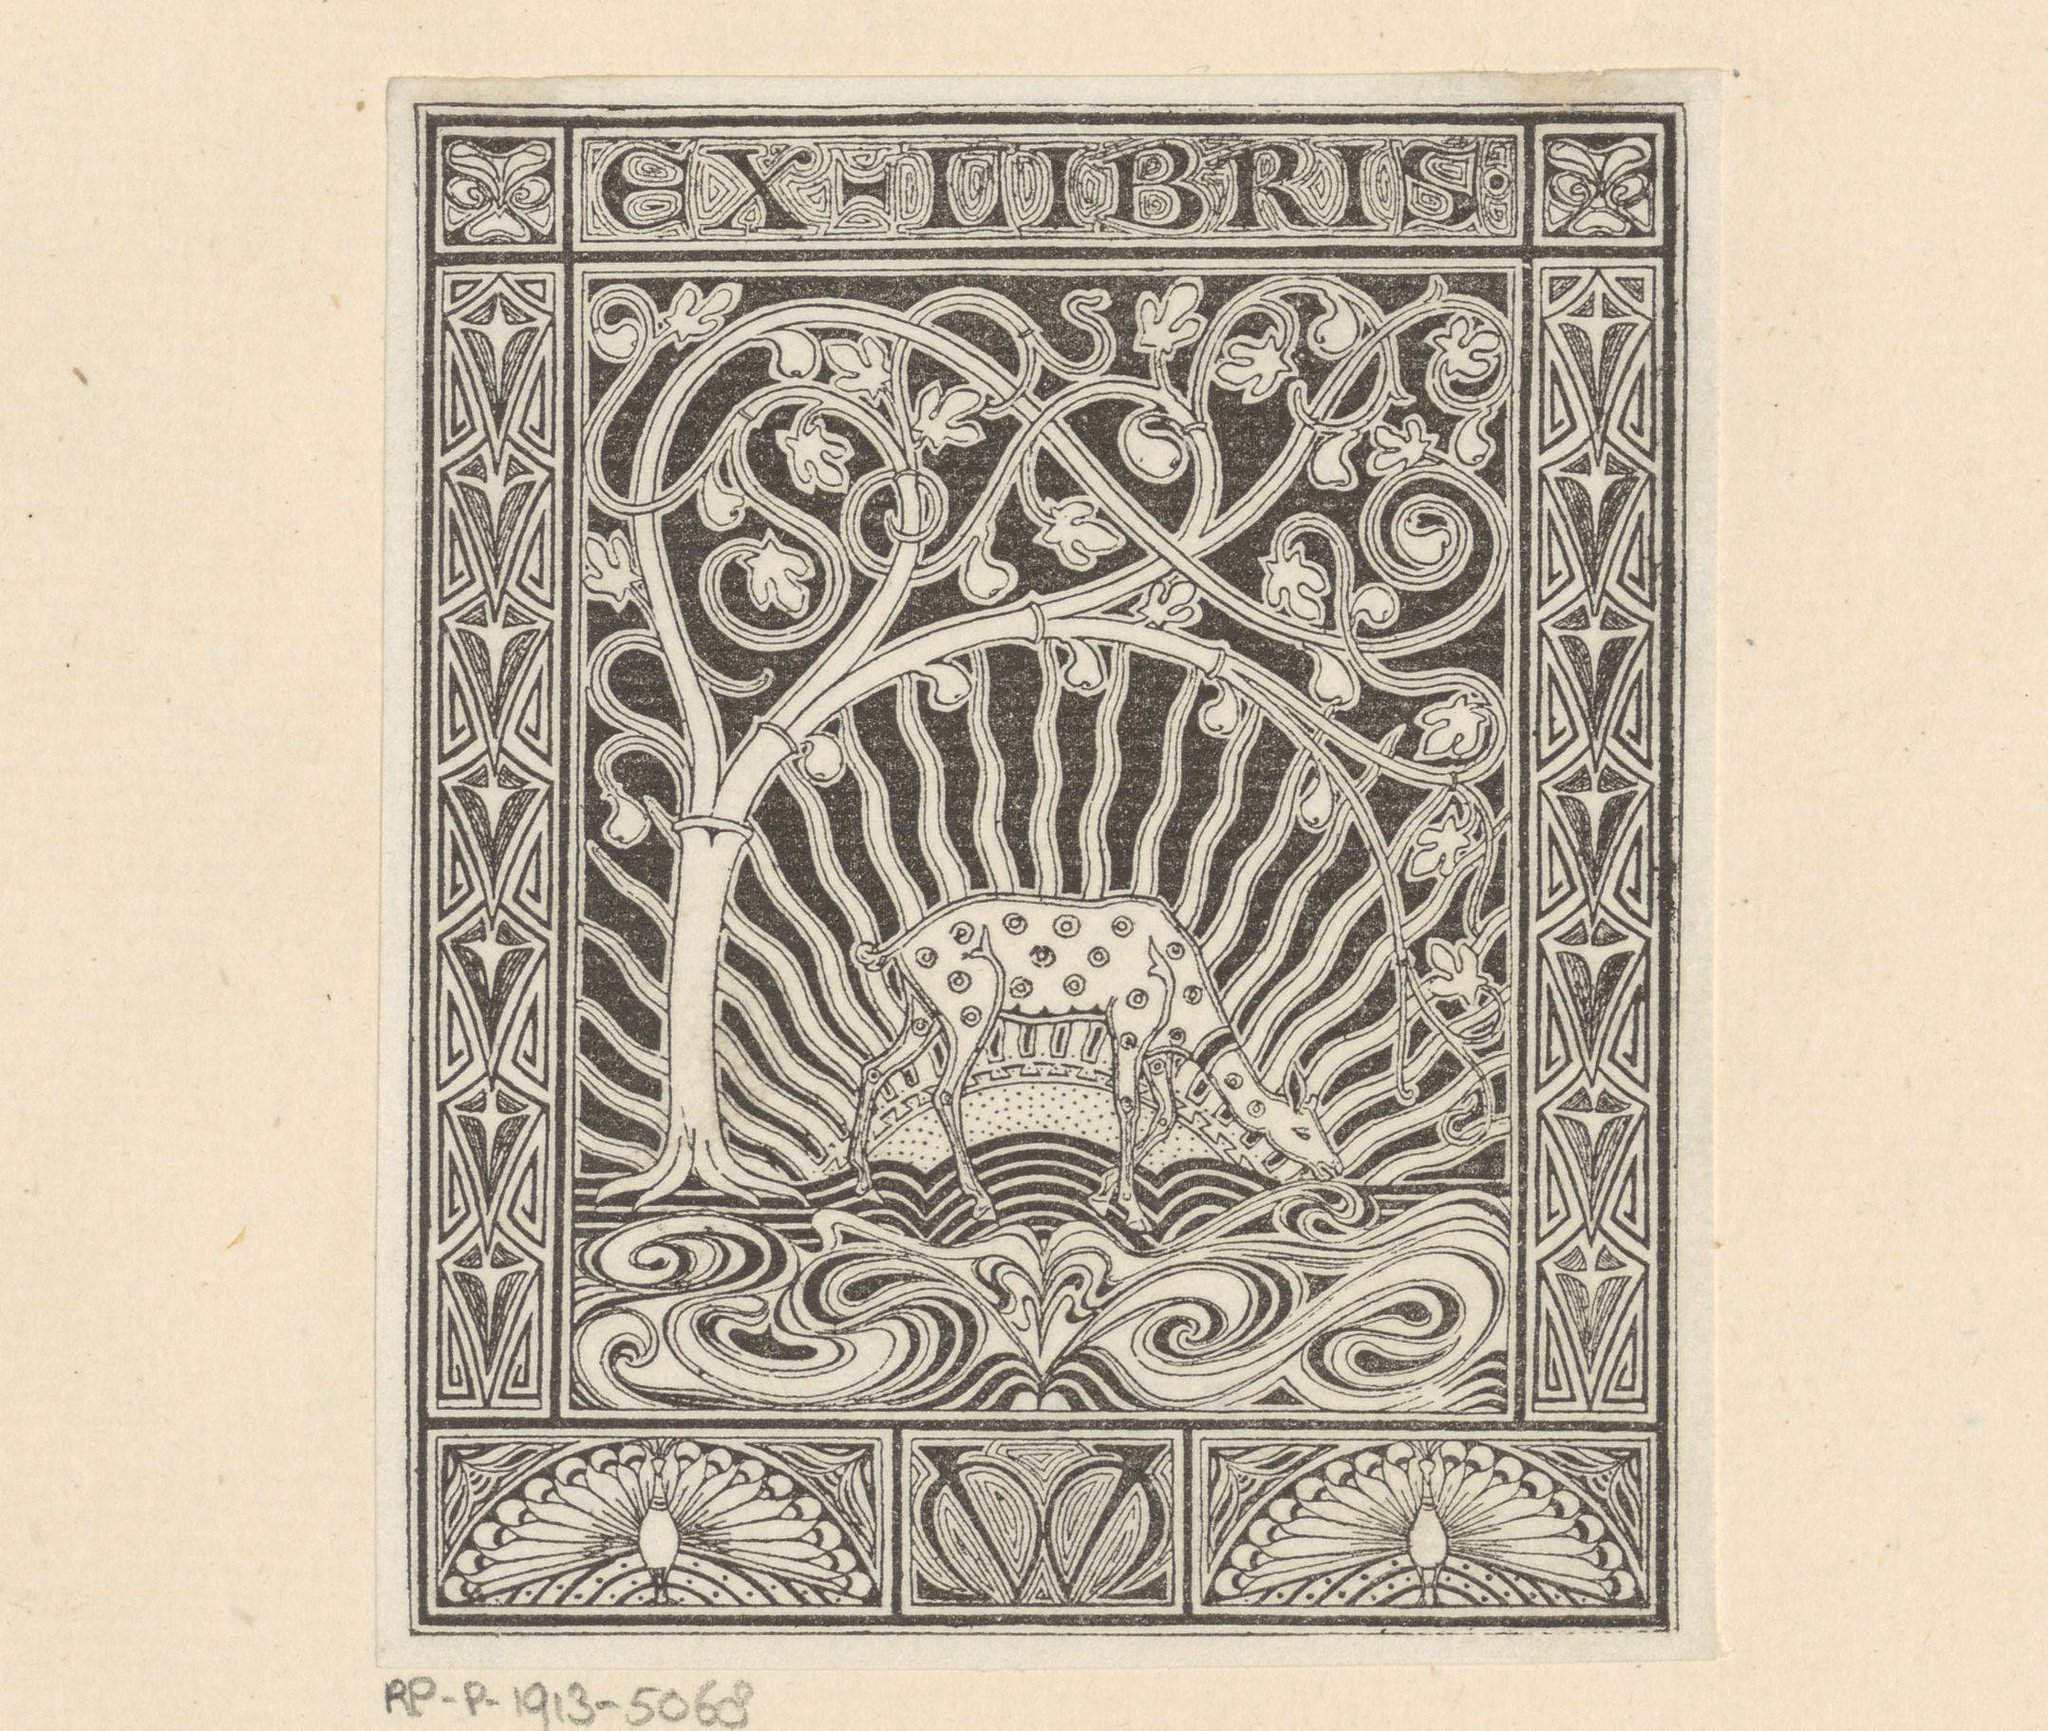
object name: bookplate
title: Ex libris van W.M.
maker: Anonymous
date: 1897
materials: paper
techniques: printing block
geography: netherlands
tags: amsterdam, draughtsman, wally moes, hoofed animals: deer, trees: fig-tree, ornamental birds: peacock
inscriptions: collector's mark: Lugt 2760, collector's mark: Lugt 2233